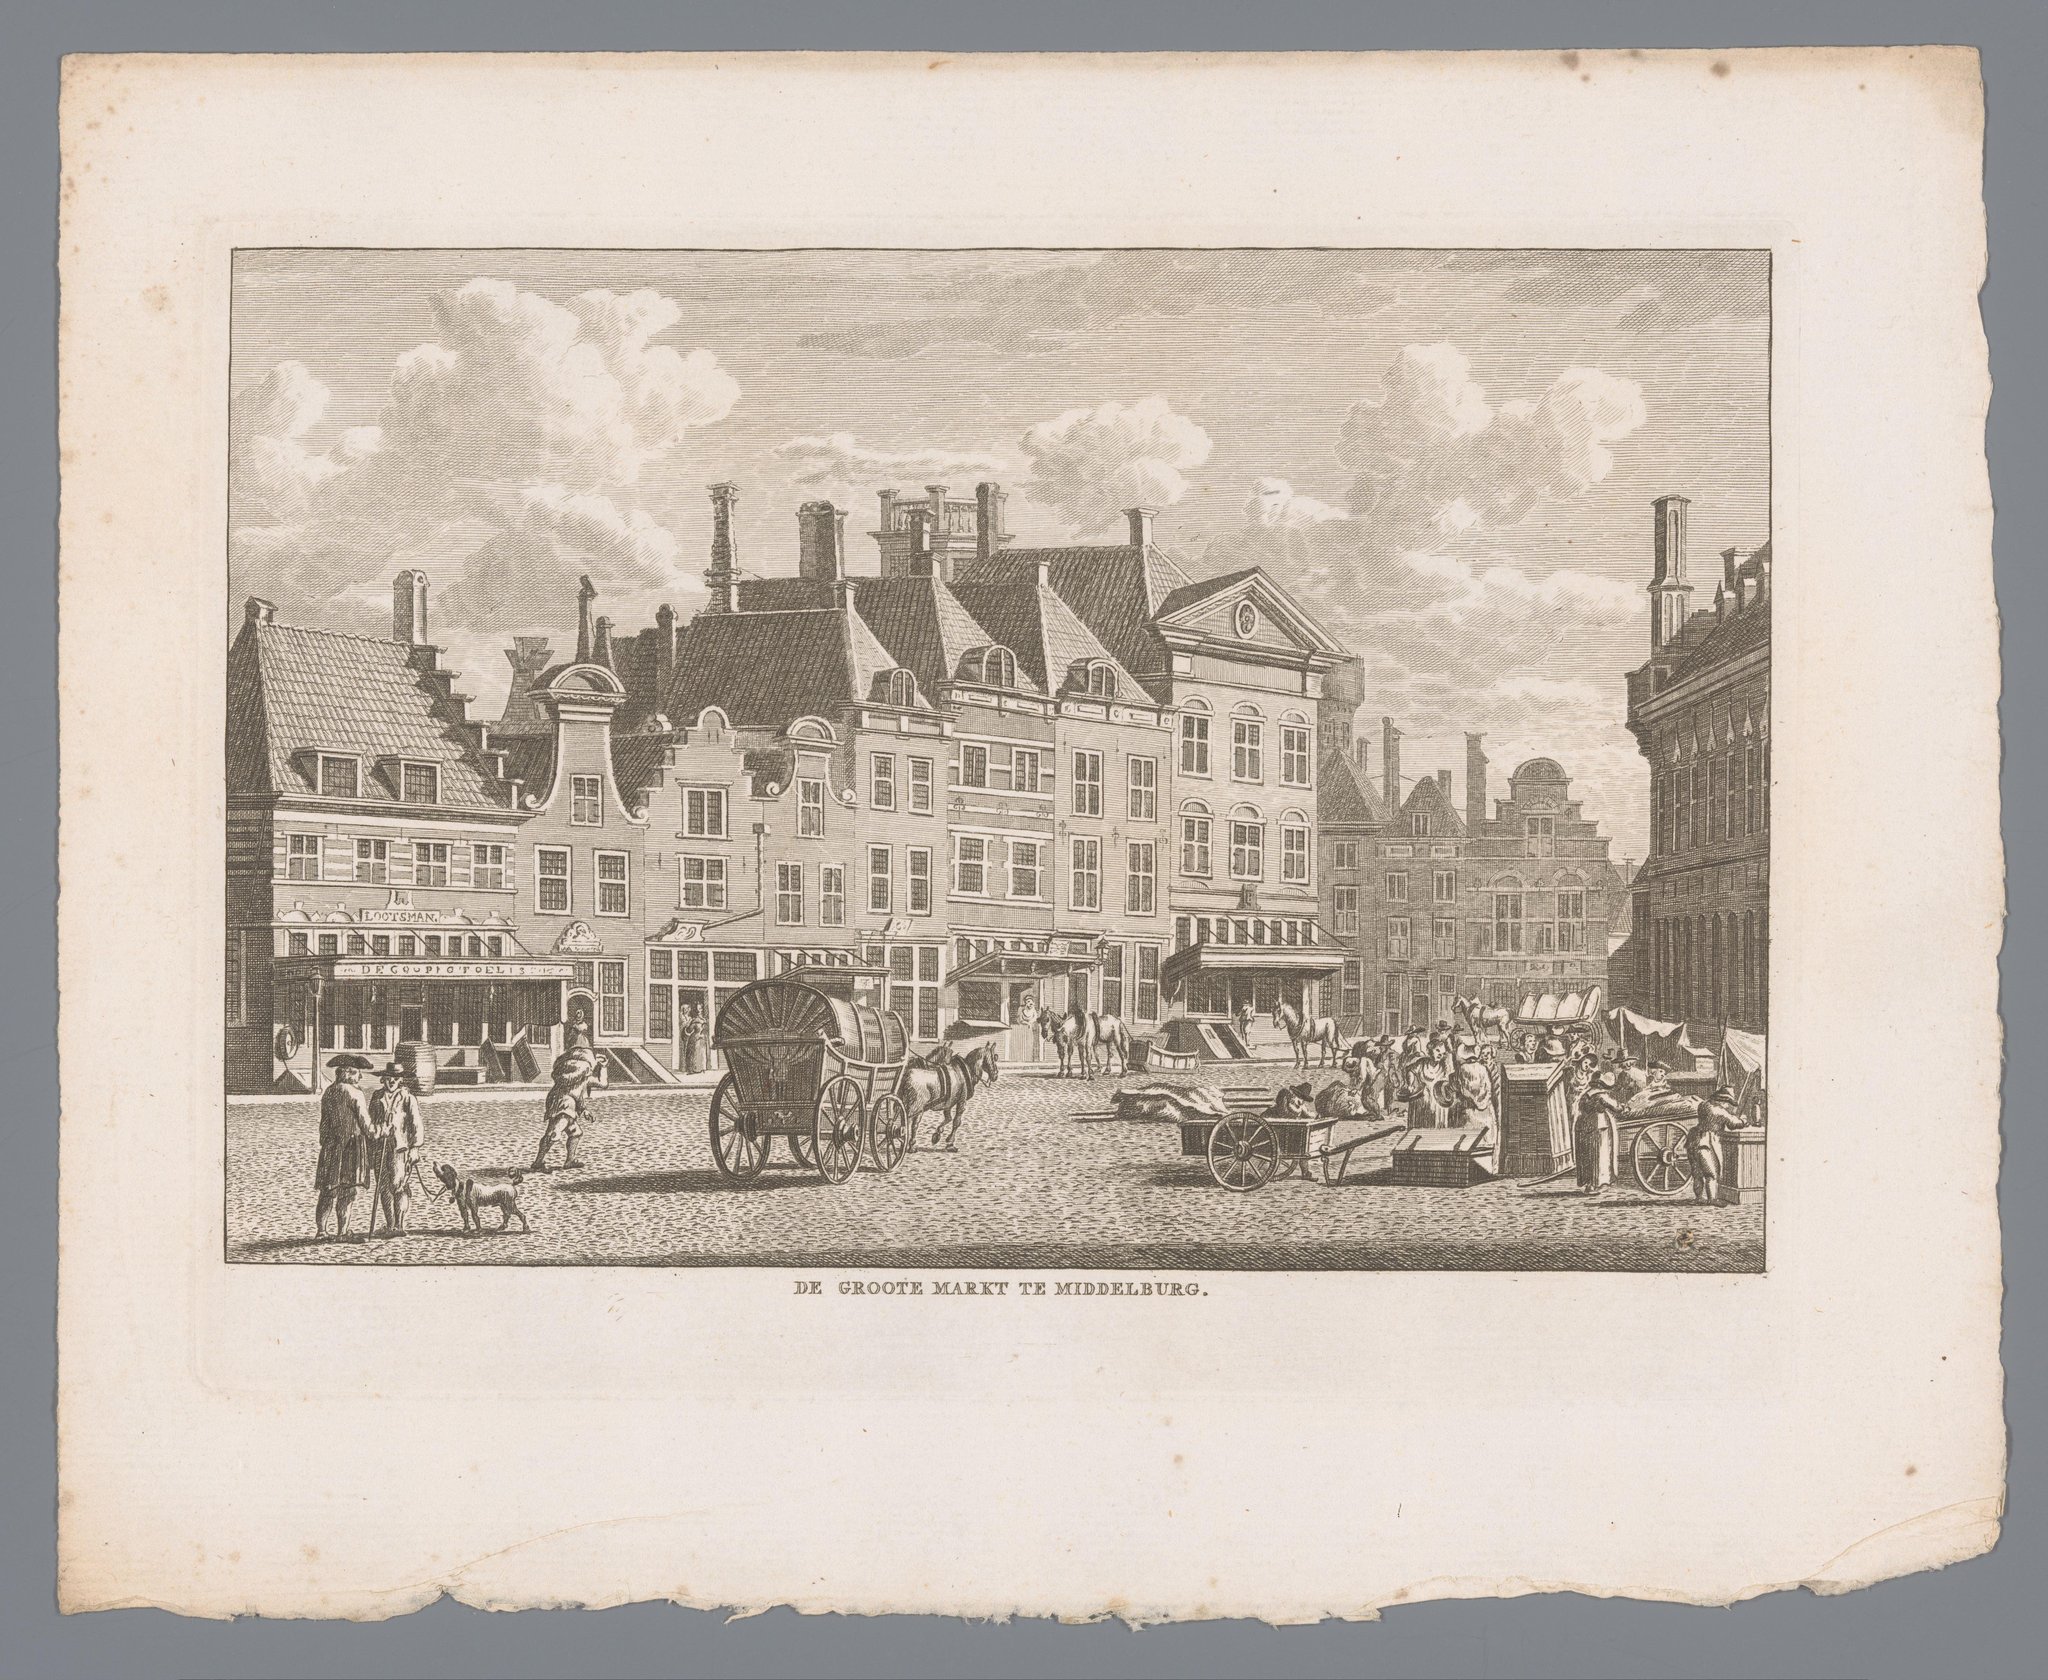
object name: print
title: De Groote Markt te Middelburg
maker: carel frederik bendorp (i)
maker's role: print maker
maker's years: 1736-1814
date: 1786-1792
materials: paper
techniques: etching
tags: market, square, place, circus, etc. (+ city(-scape) with figures, staffage)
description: Prent uit: Vaderlandsche gezichten, of afbeeldingen van den tegenwoordigen staat der Vereenigde Nederlanden (…). Amsterdam: Hendrik Gartman, Willem Vermandel en Jan Willem Smit, 1786-1792. Uitgegeven in afleveringen met ieder een eigen bifolium en inhoudsopgave. Alle prenten in deze publicatie zijn gegraveerd door Carel Frederik Bendorp (I) en, in de meeste gevallen, gebaseerd op tekeningen van Jan Bulthuis.